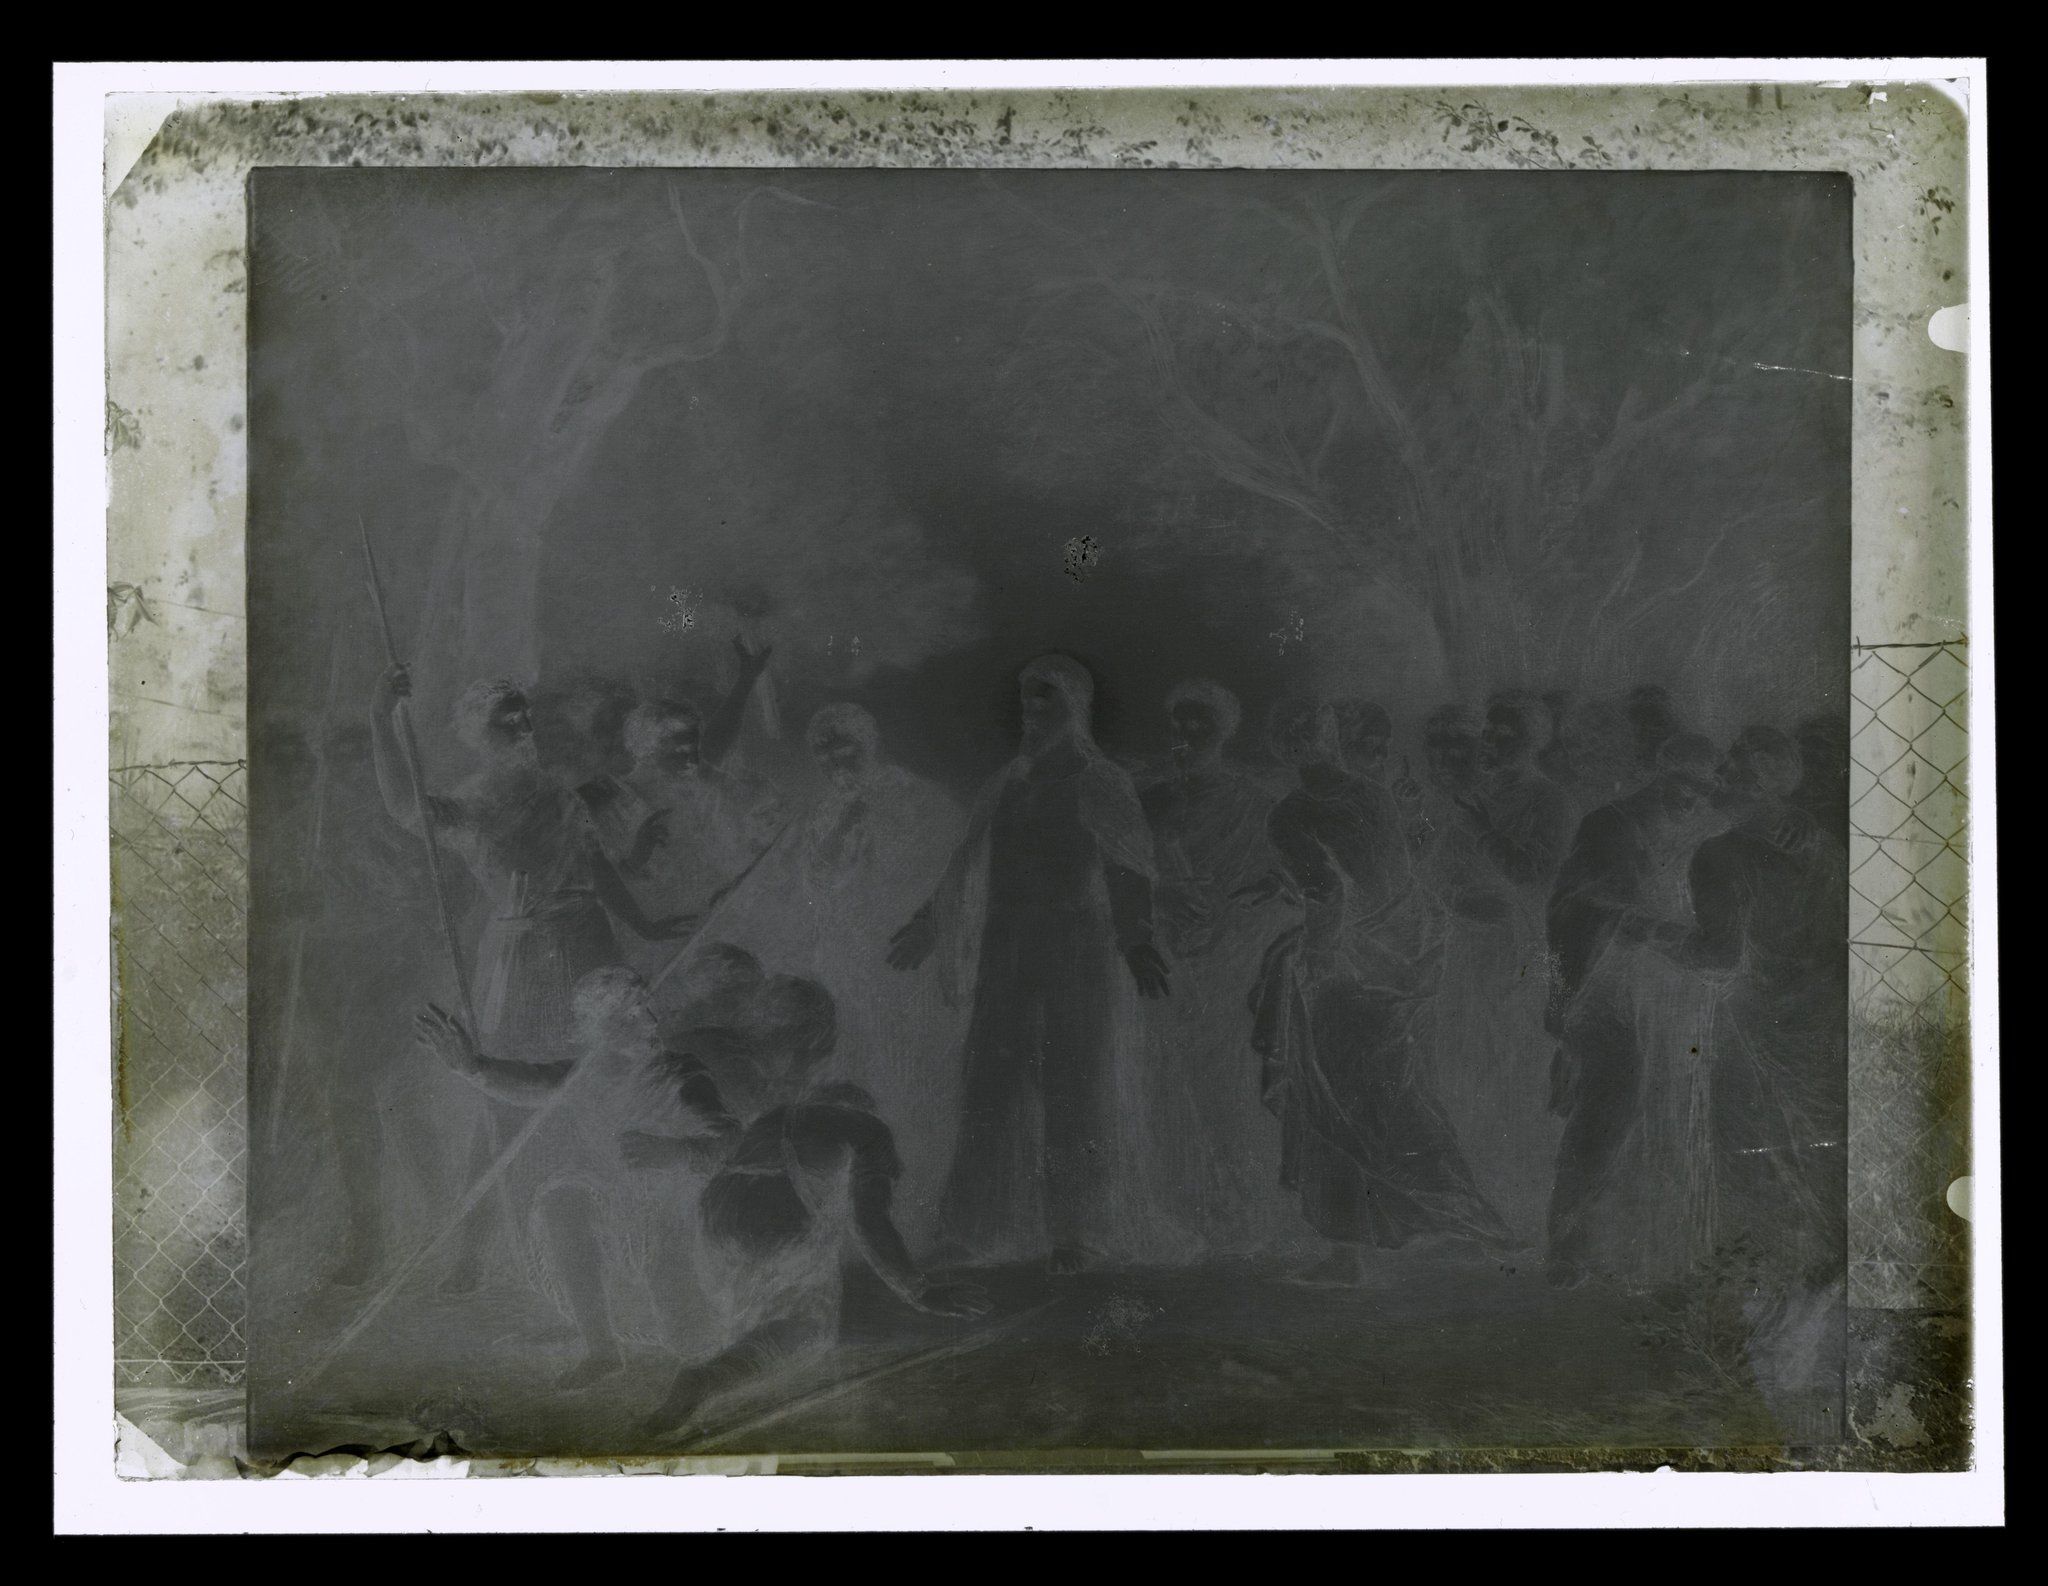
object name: glasnegatief, glasplaatnegatief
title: Fotoreproductie van een schilderij van Christus in een bos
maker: laurens lodewijk kleijn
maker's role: draughtsman, painter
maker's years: 1826-1909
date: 1865-1900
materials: glass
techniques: collodion process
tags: picture, painting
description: Onderdeel van groep glasnegatieven uit de nalatenschap van de schilder Laurens Lodewijk Kleijn, stillevens, portretten, zelfportretten en kunstreproducties.